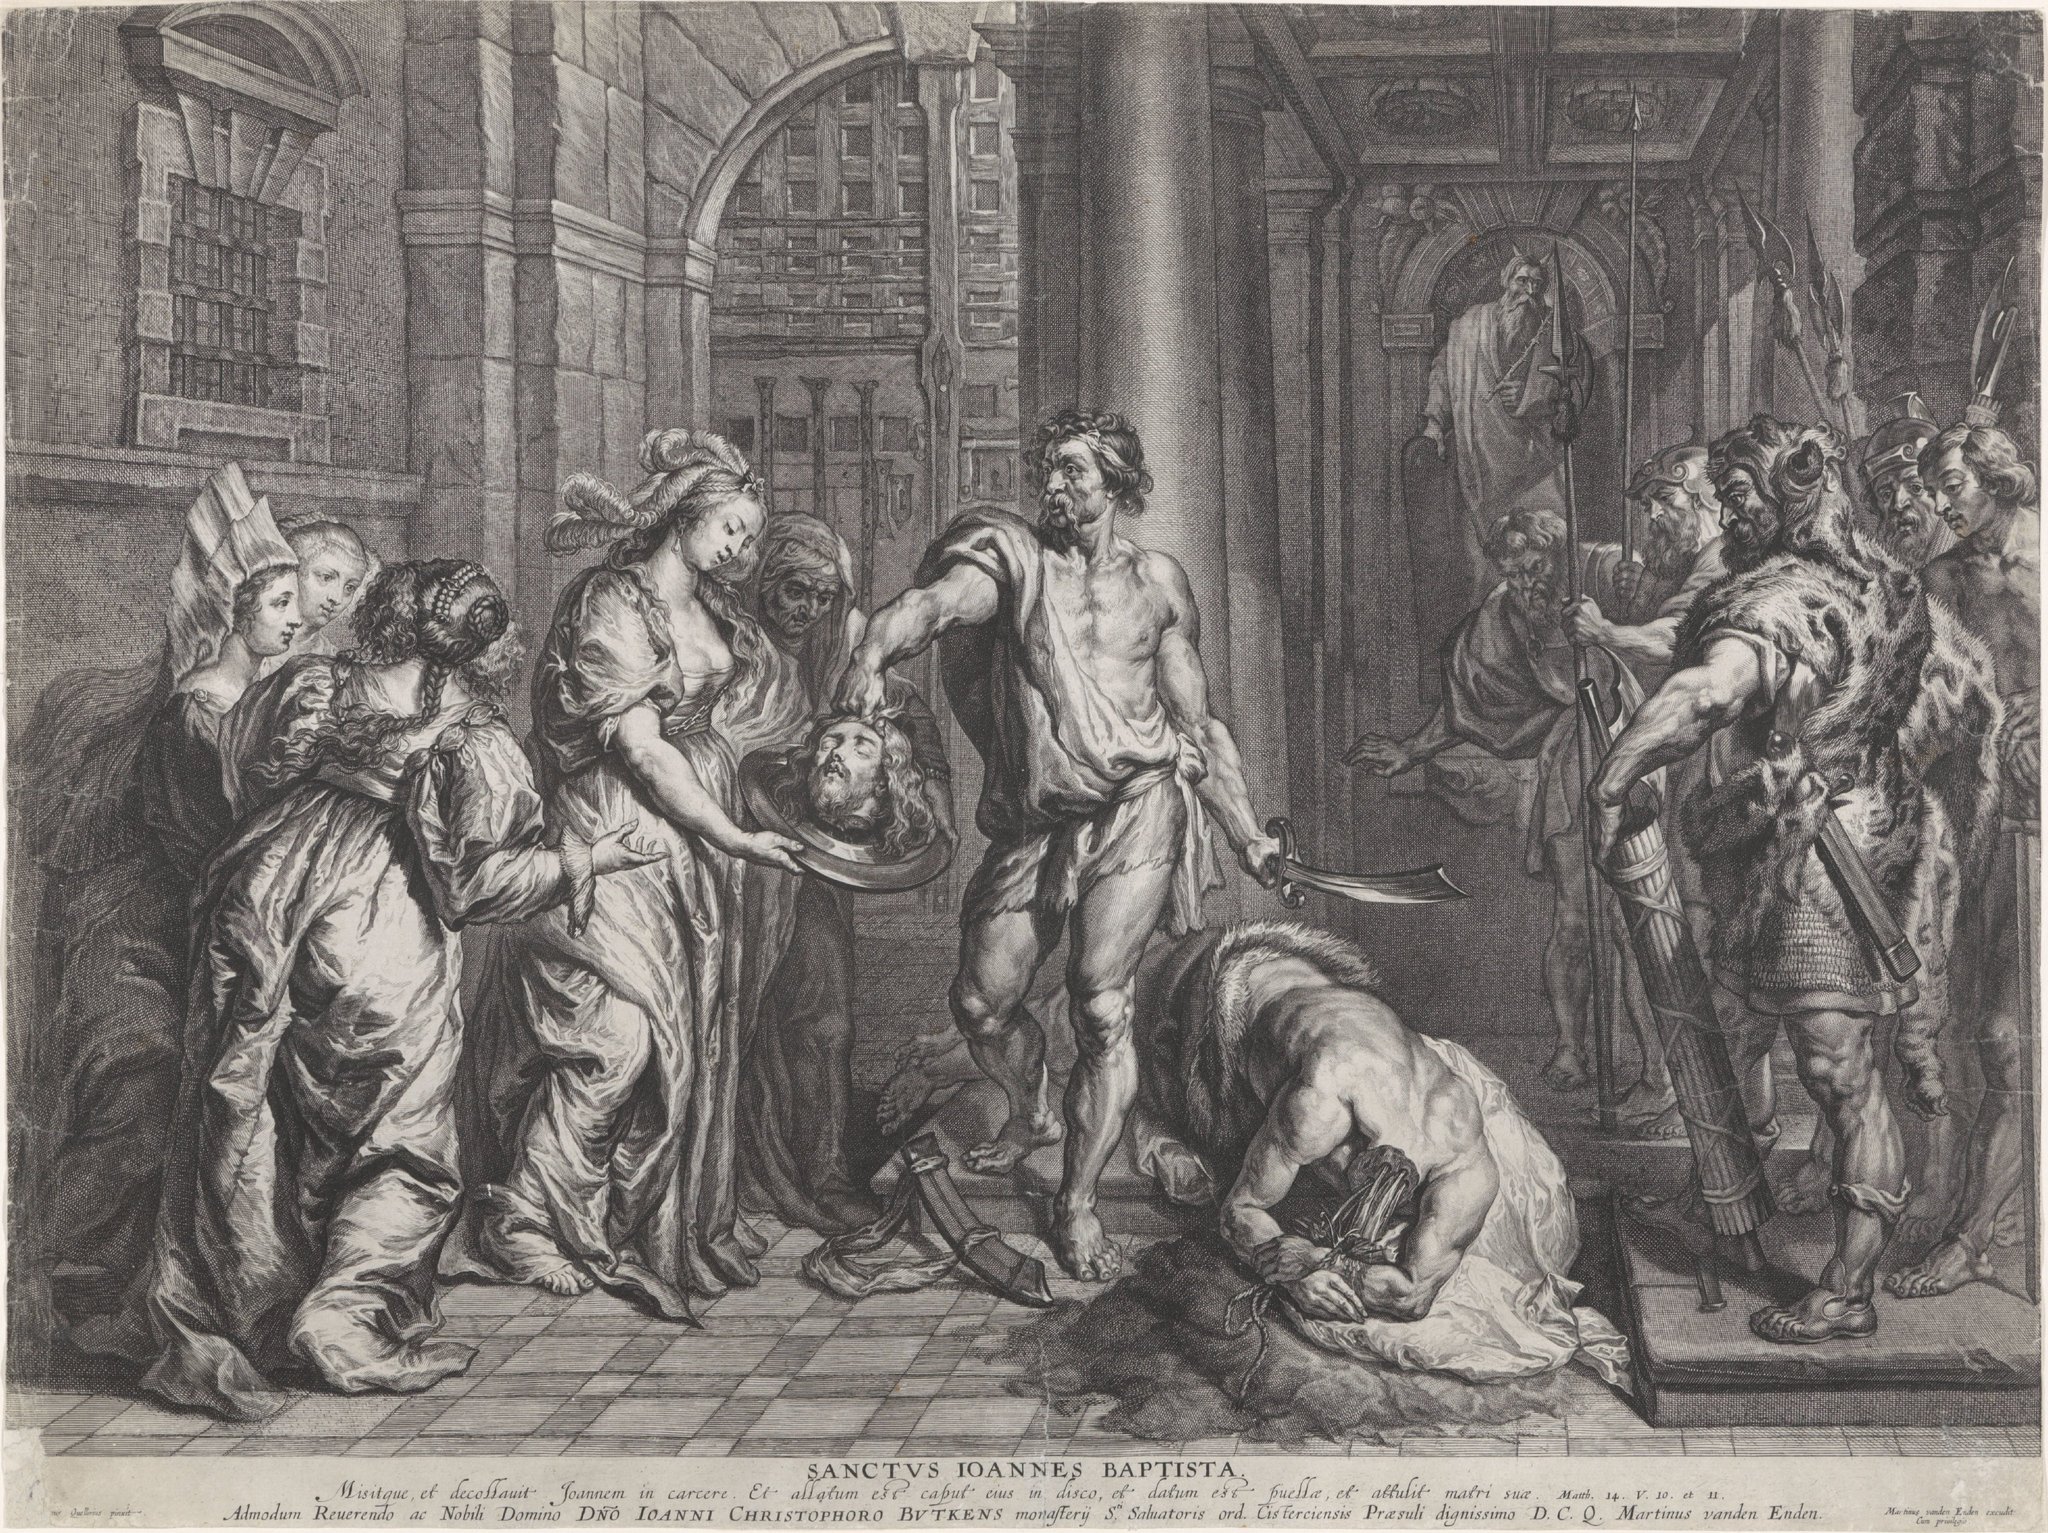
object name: print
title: Onthoofding van Johannes de Doper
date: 1645-1650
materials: paper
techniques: engraving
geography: antwerp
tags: salome is given the head of john the baptist by the executioner, moses (not in biblical context); possible attributes: rays of light or horns on his head, rod, tables of the law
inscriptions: collector's mark: Lugt 2228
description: De beul legt het hoofd van Johannes de Doper op de schaal, die Salomé en haar moeder Herodias vasthouden. Links kijken drie vrouwen toe. Rechts staan soldaten, waarvan er een gekleed is in een leeuwenvel en een fasces in de hand houdt. Op de achtergrond in een nis een standbeeld van Mozes met de tafelen van de wet.